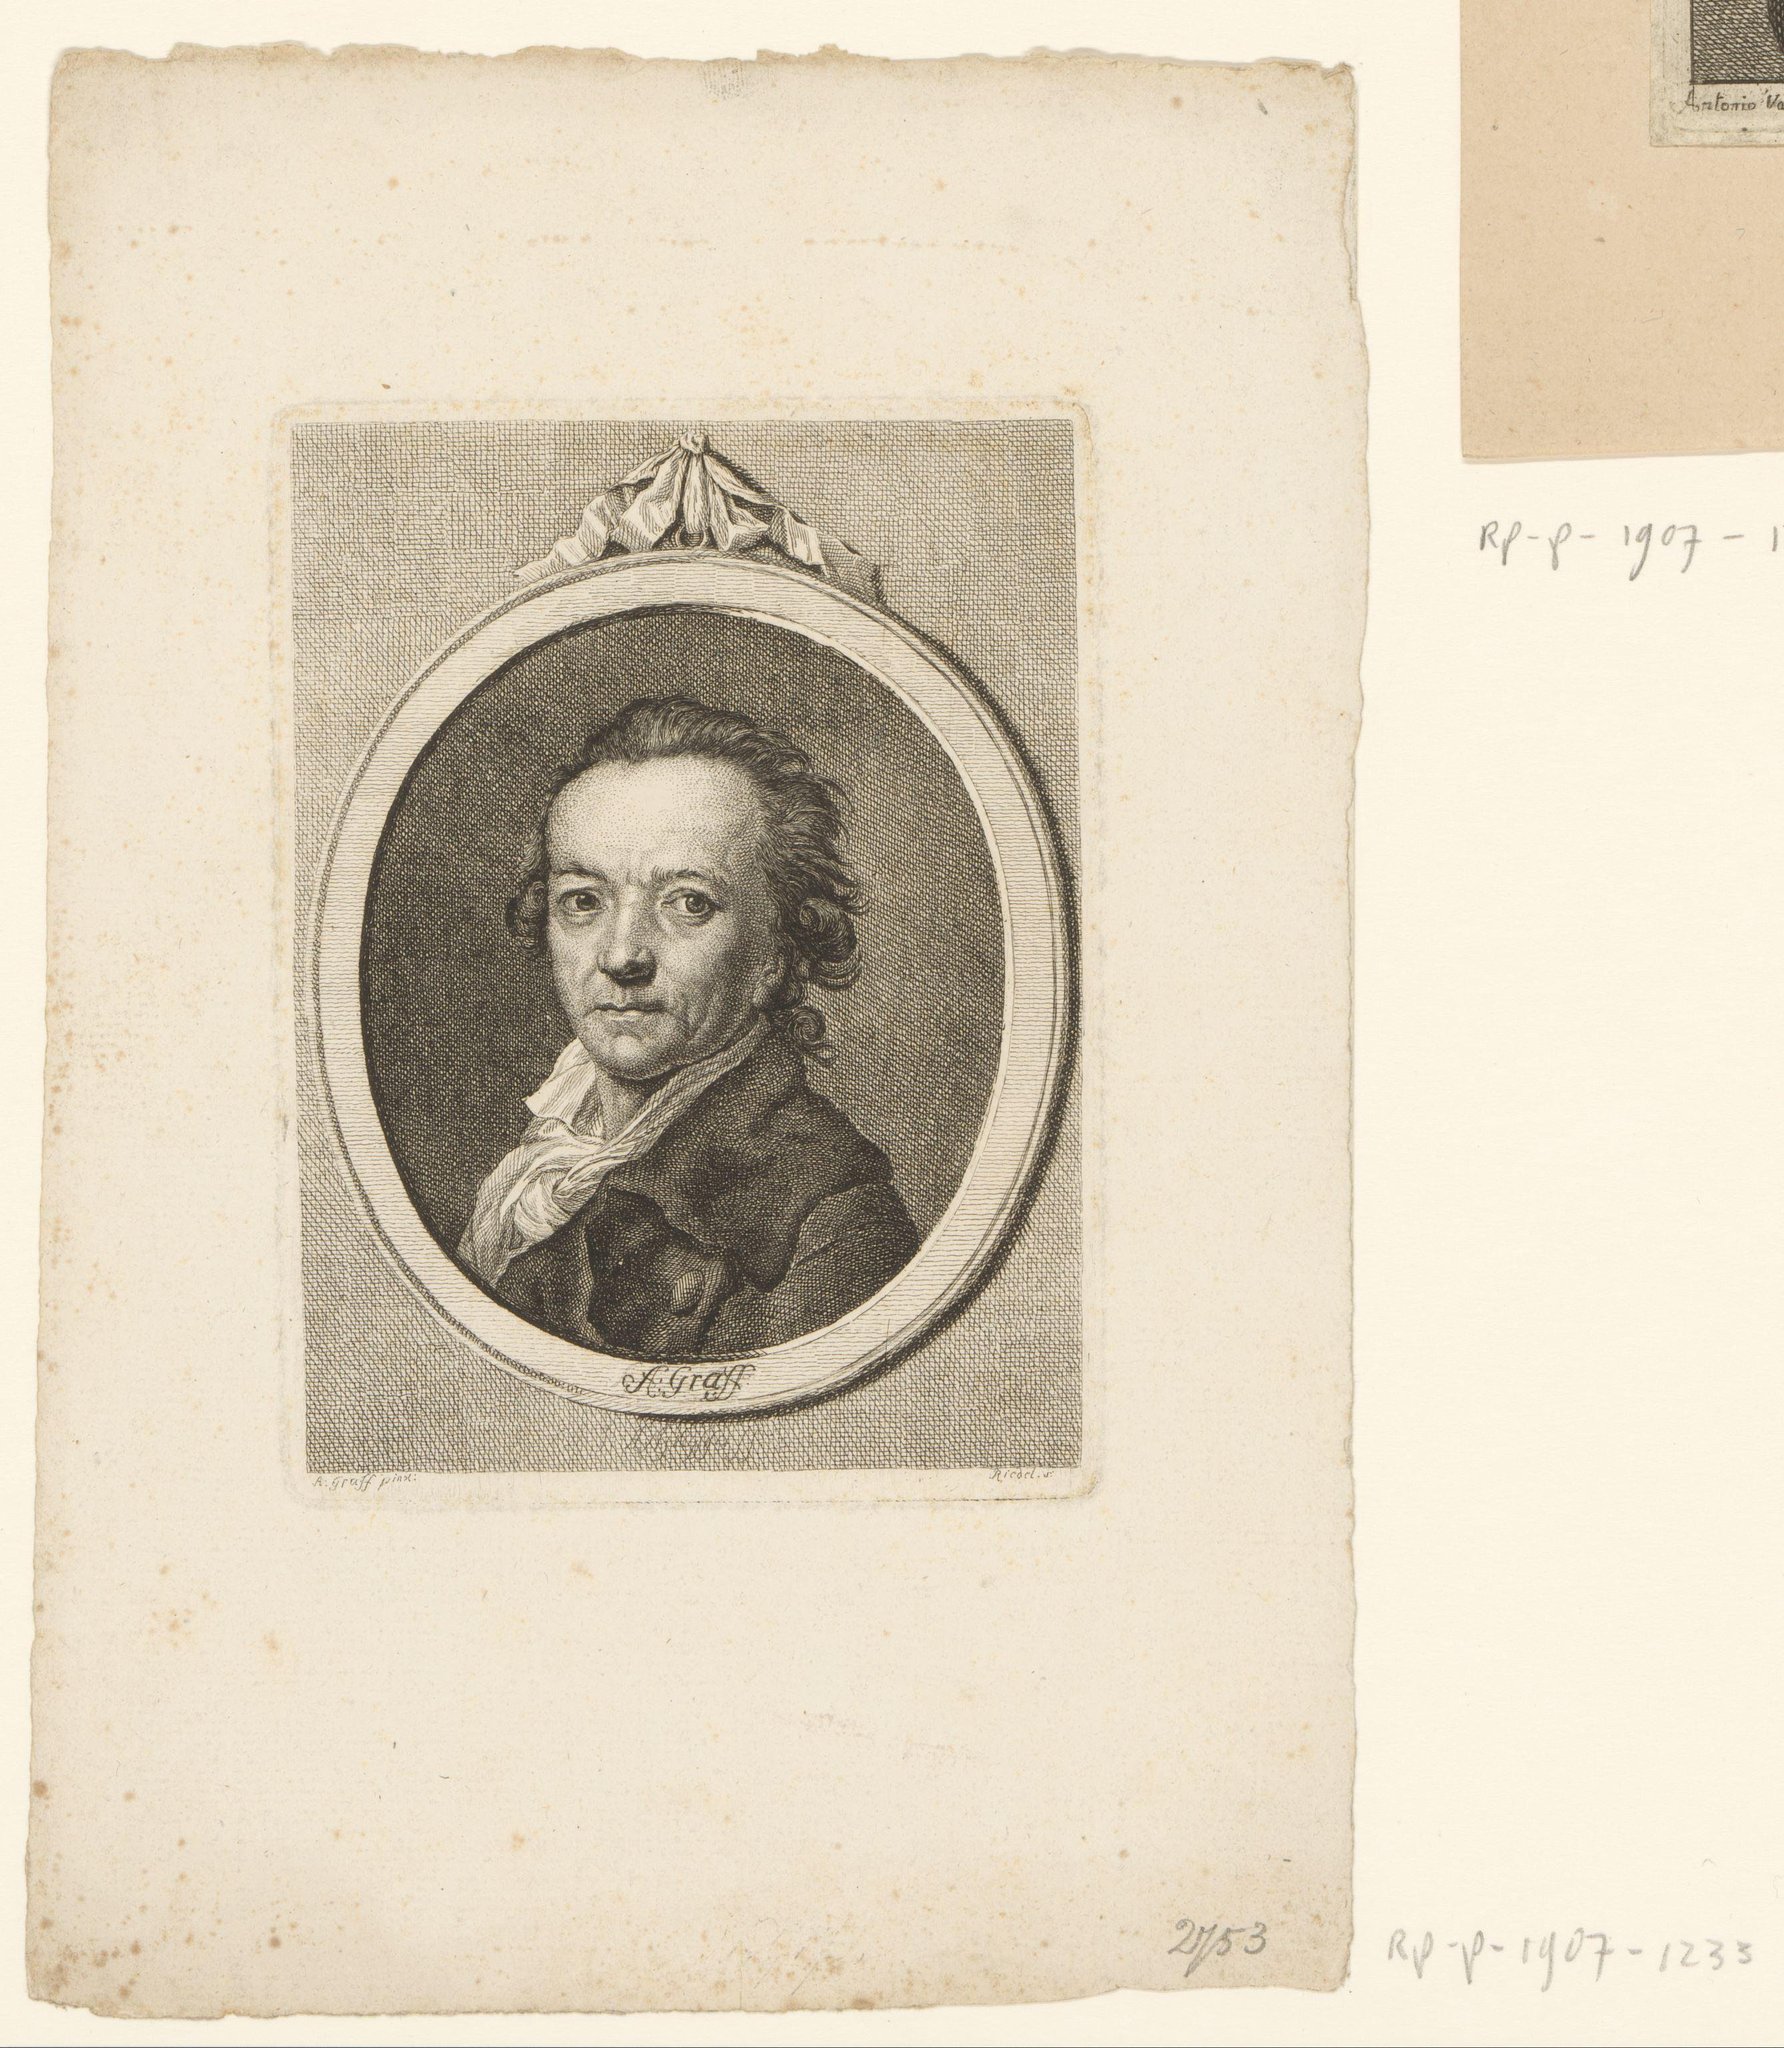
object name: print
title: Portret van Anton Graff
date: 1746-1816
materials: paper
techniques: etching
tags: painter, print maker, anton graff, historical persons, portrait, self-portrait of painter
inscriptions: collector's mark: Lugt 2228